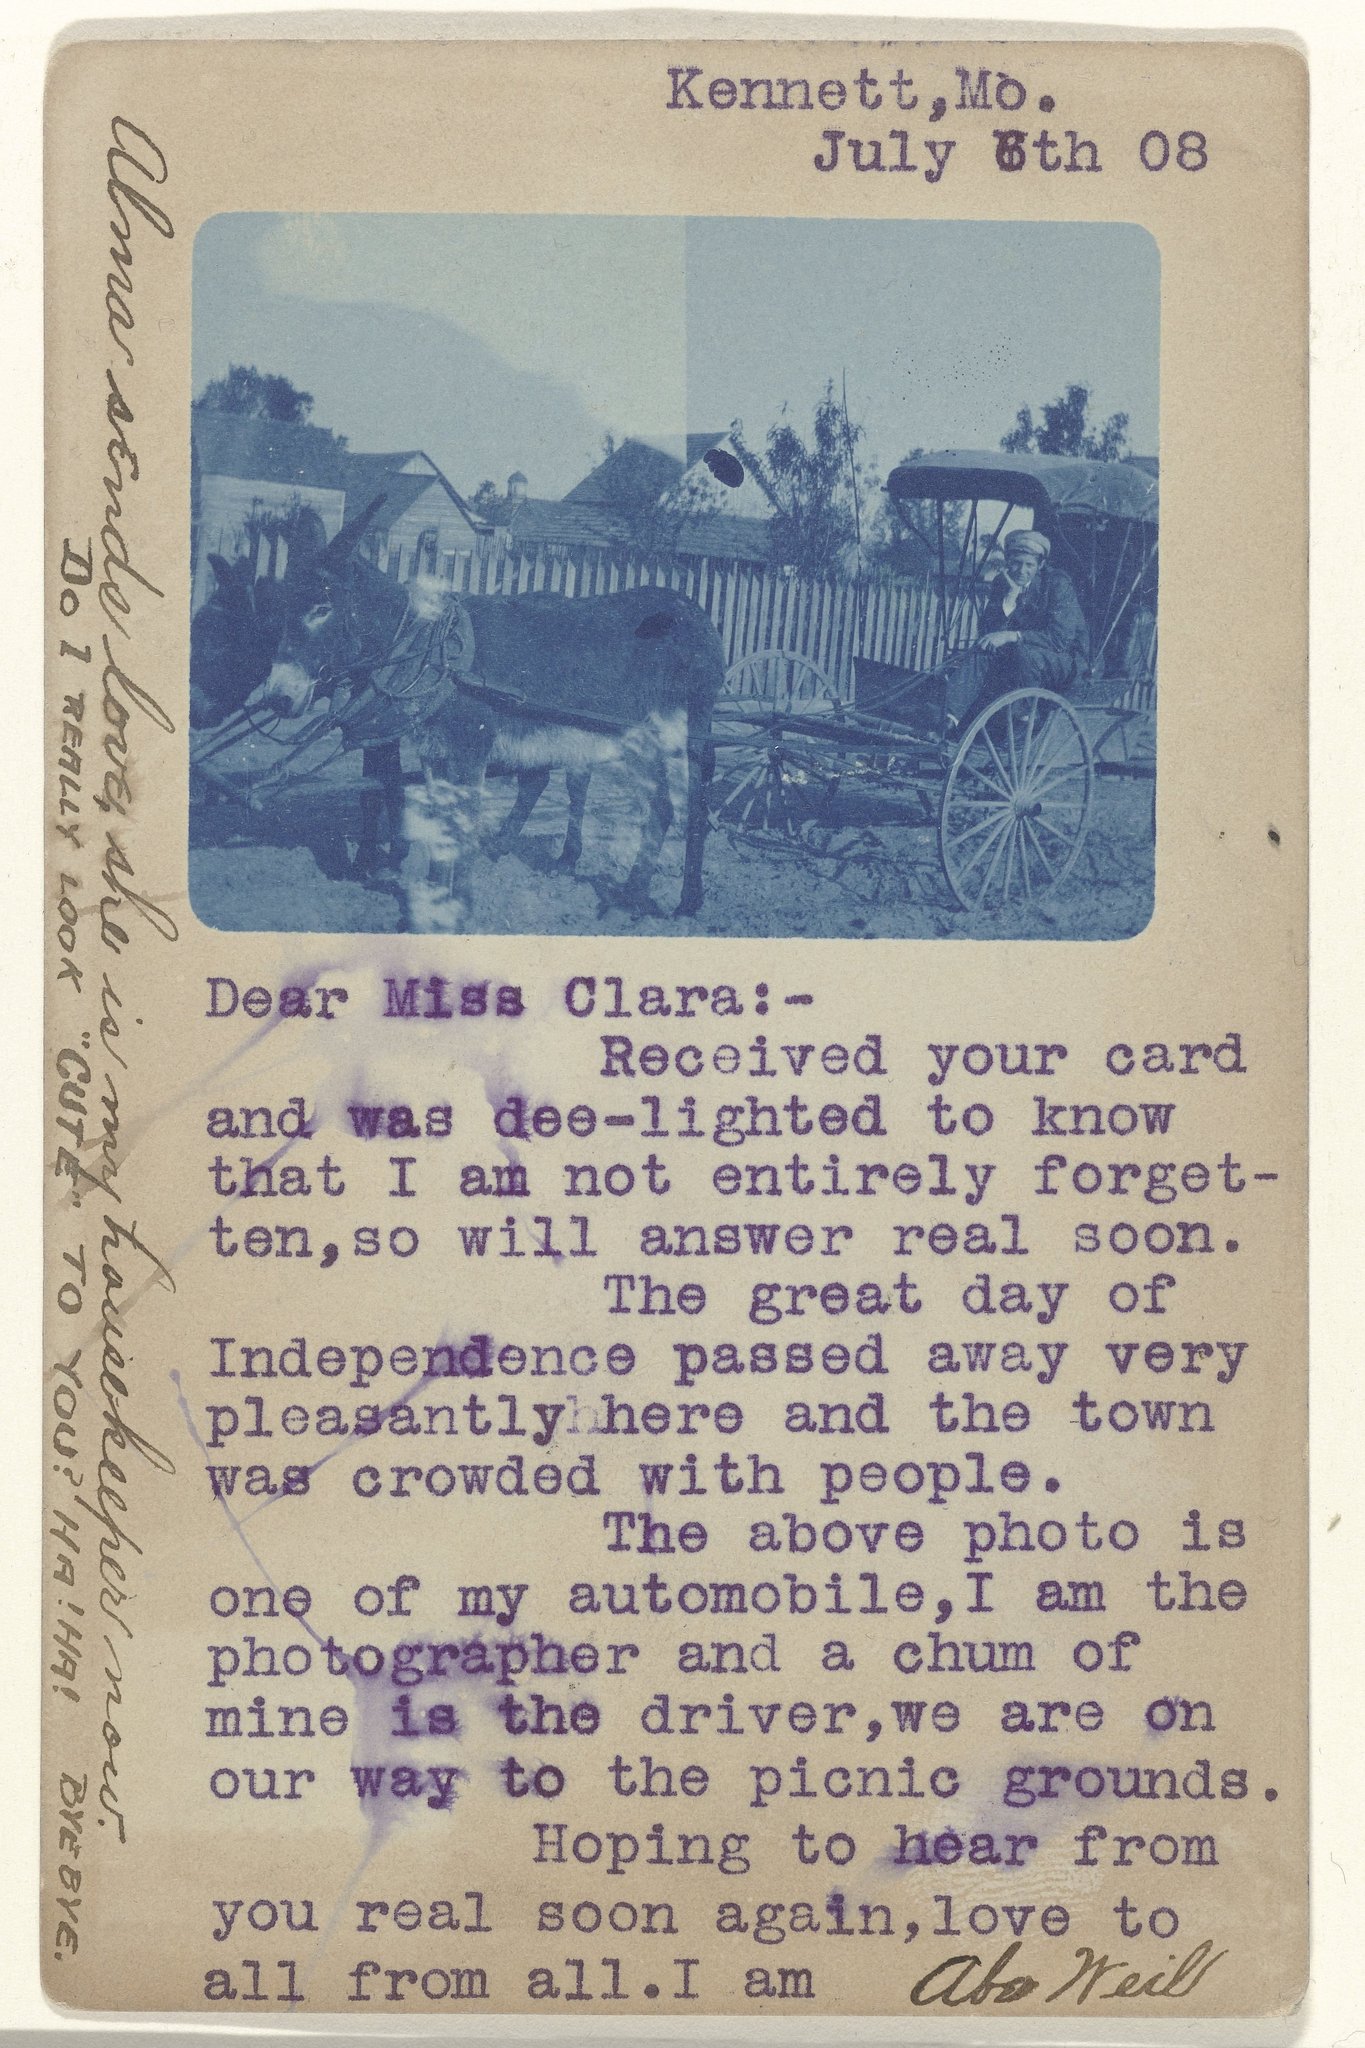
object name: ansichtkaart, prentbriefkaart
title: Jongen in een koets met twee ezels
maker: abe weil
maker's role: fotograaf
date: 1908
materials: paper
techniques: cyanotype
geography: missouri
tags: four-wheeled vehicle drawn by two animals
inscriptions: dedication: ‘POST CARD // CORRESPONDANCE // ADDRESS’, stamp: ‘KENNETT // 1908 // [...]’, inscription: ‘I understand that my old // time girl is expected to // make a visit to our little // city, but she is MARRIED now. 'Booty" Limbaugh was // in the store last Saturday // How is "Bun"? I wonder if // She has ever learned to // waltz. I feel awfully good // when I think over the many // pleasent hours spent at your // home. Wish it would happen again. // [adressing:] MISS CLARA MUELLER, // JACKSON, // MO.’, inscription: ‘Alma sends love, she is my housekeeper now. // DO I REALLY LOOK "CUTE" TO YOU? HA! HA! BYE BYE.’, inscription: ‘Kennet, Mo. // July 6th 08 // Dear Miss Clara // Received your card // and was dee-lighted to know // that I am not entirely forget- [sic] // ten, so will answer soon. // The geat day of // Independence passes away very // pleasantly here and the town // was crowded with people. // The above photo // is one of my automobile. I am the // photographer and a chum of // mine is the driver, we are on // our way to the picnic grounds. // Hoping to hear from // you real soon again, love to // all from all. I am Abe Weil (in potlood).’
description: Op het blad een brief geschreven door de fotograaf en eigenaar van de koets, in Kennett in de staat Missouri op 6 juli 1908.